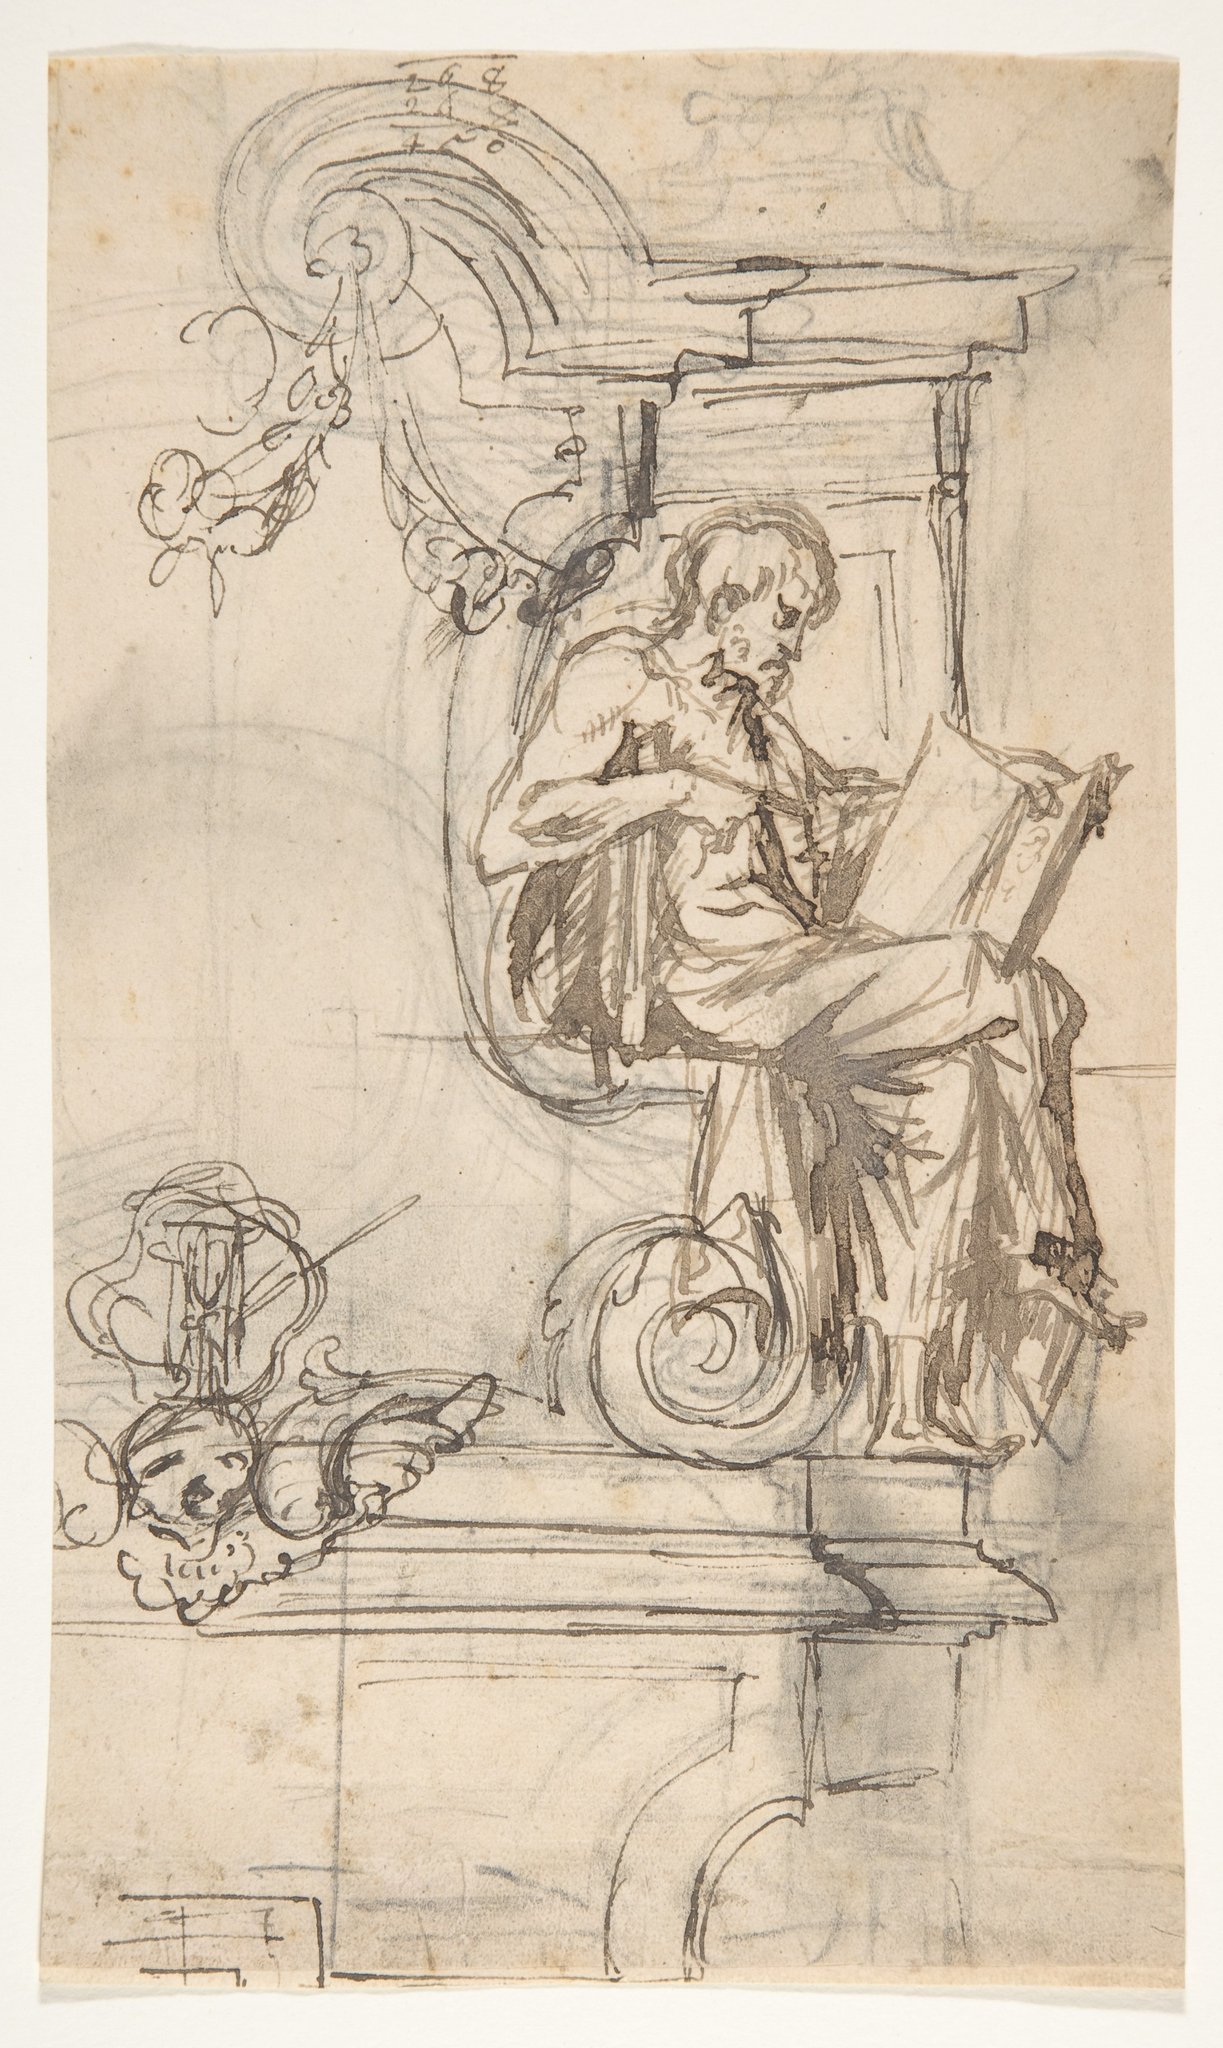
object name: drawing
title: Design for a sepulchral monument with a seated prophet or philosopher (recto); Sketches (verso)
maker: pieter verbruggen the younger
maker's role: artist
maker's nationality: flemish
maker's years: 1648-1691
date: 1667-1733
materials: chalk, ink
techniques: pen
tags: men